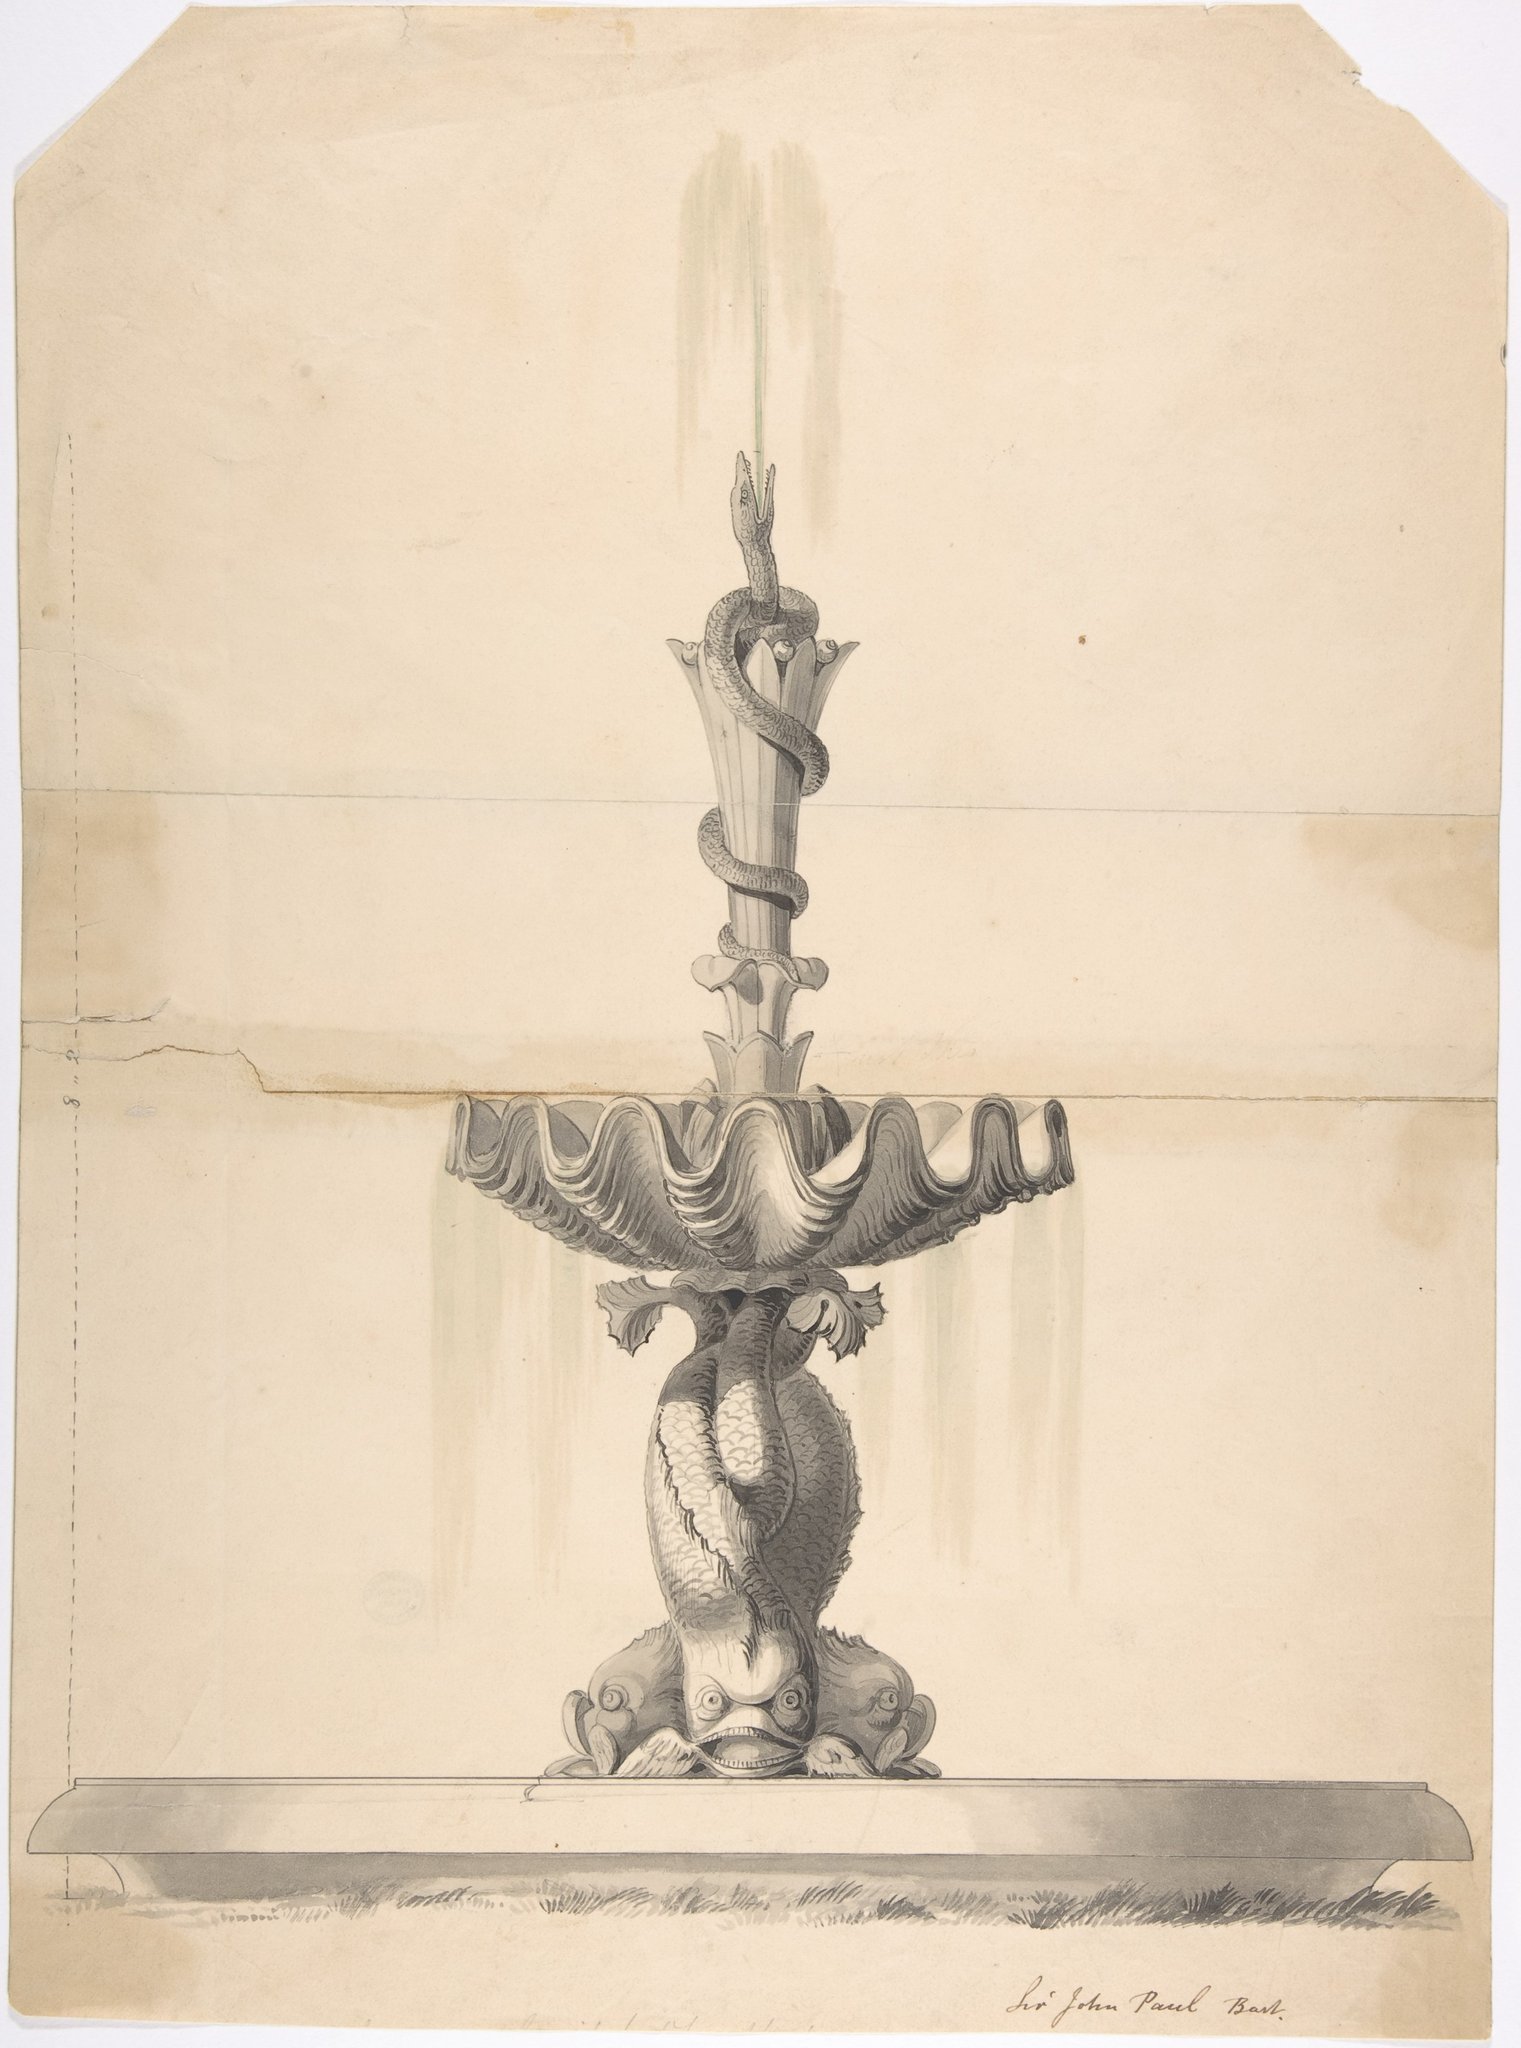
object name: drawing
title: Design for a Fountain with a Shell Basin Supported by Three Dolphins and Surmounted by a Snake Spouting Water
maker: anonymous, british, 19th century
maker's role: artist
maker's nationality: british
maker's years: 1800-1900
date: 1834-1866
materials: ink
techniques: brush, pen, wash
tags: fountains,dolphins,snakes